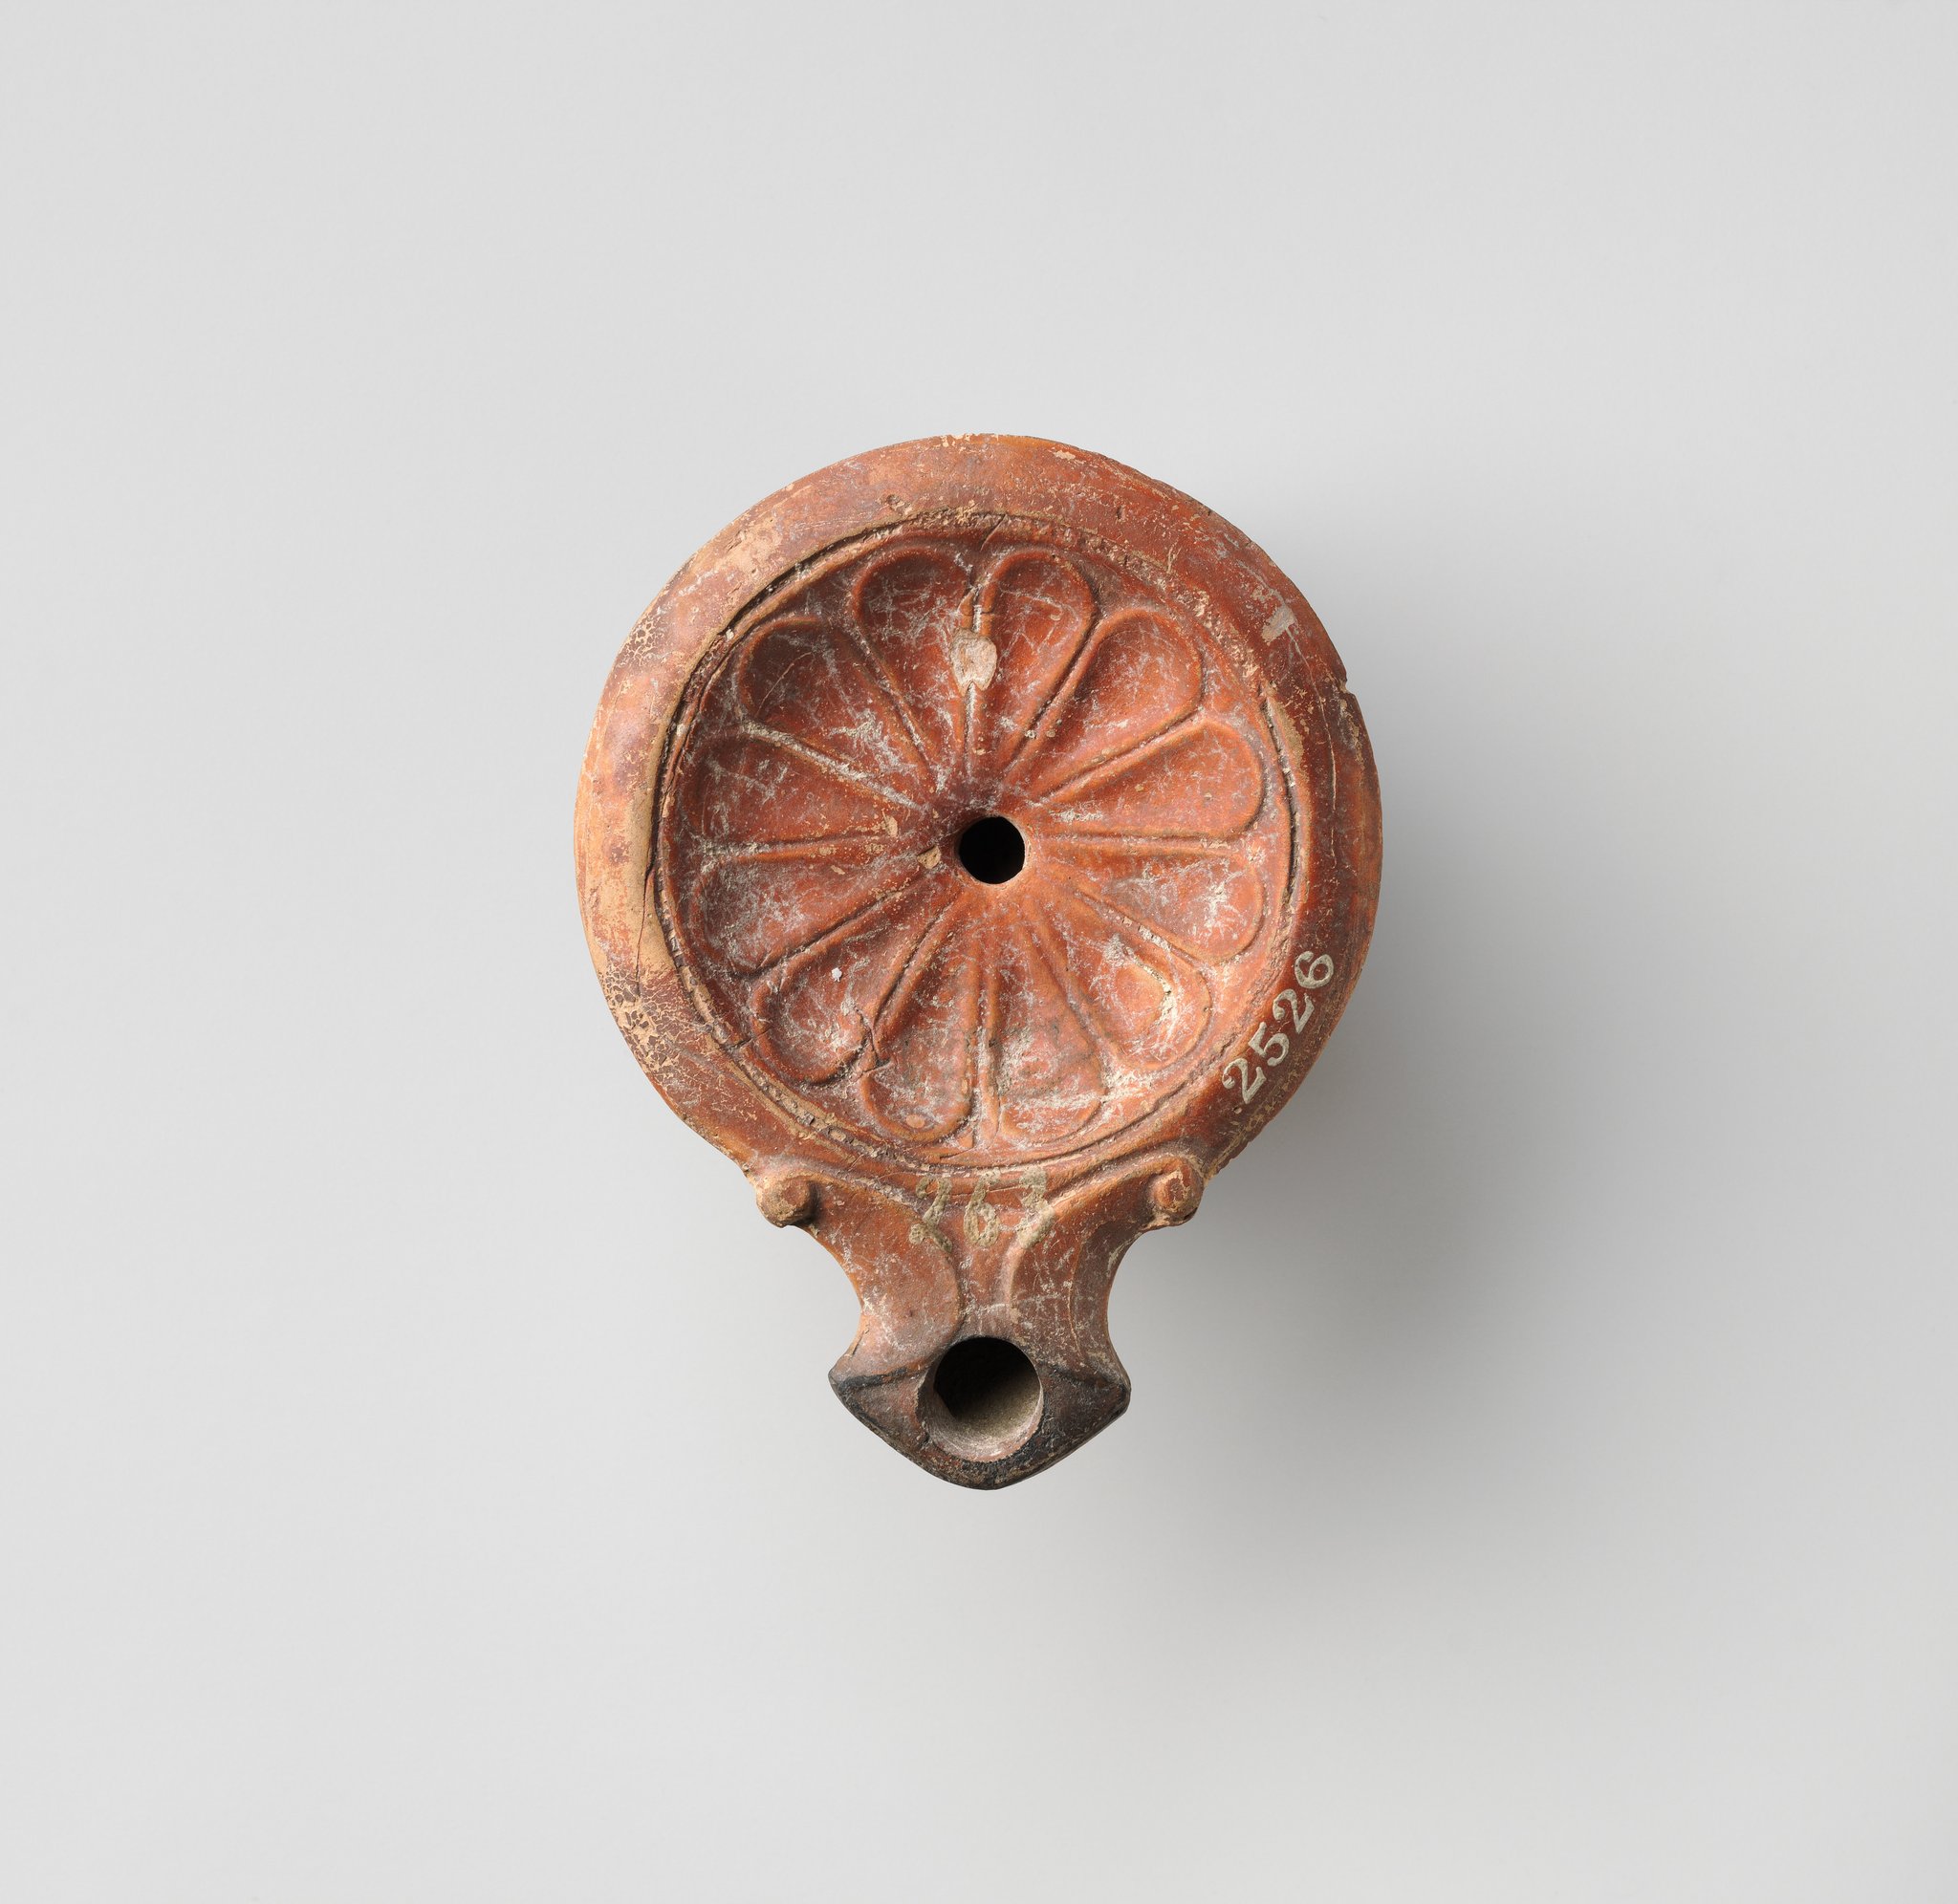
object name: lamp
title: Terracotta oil lamp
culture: roman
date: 100 BCE-100 CE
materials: terracotta